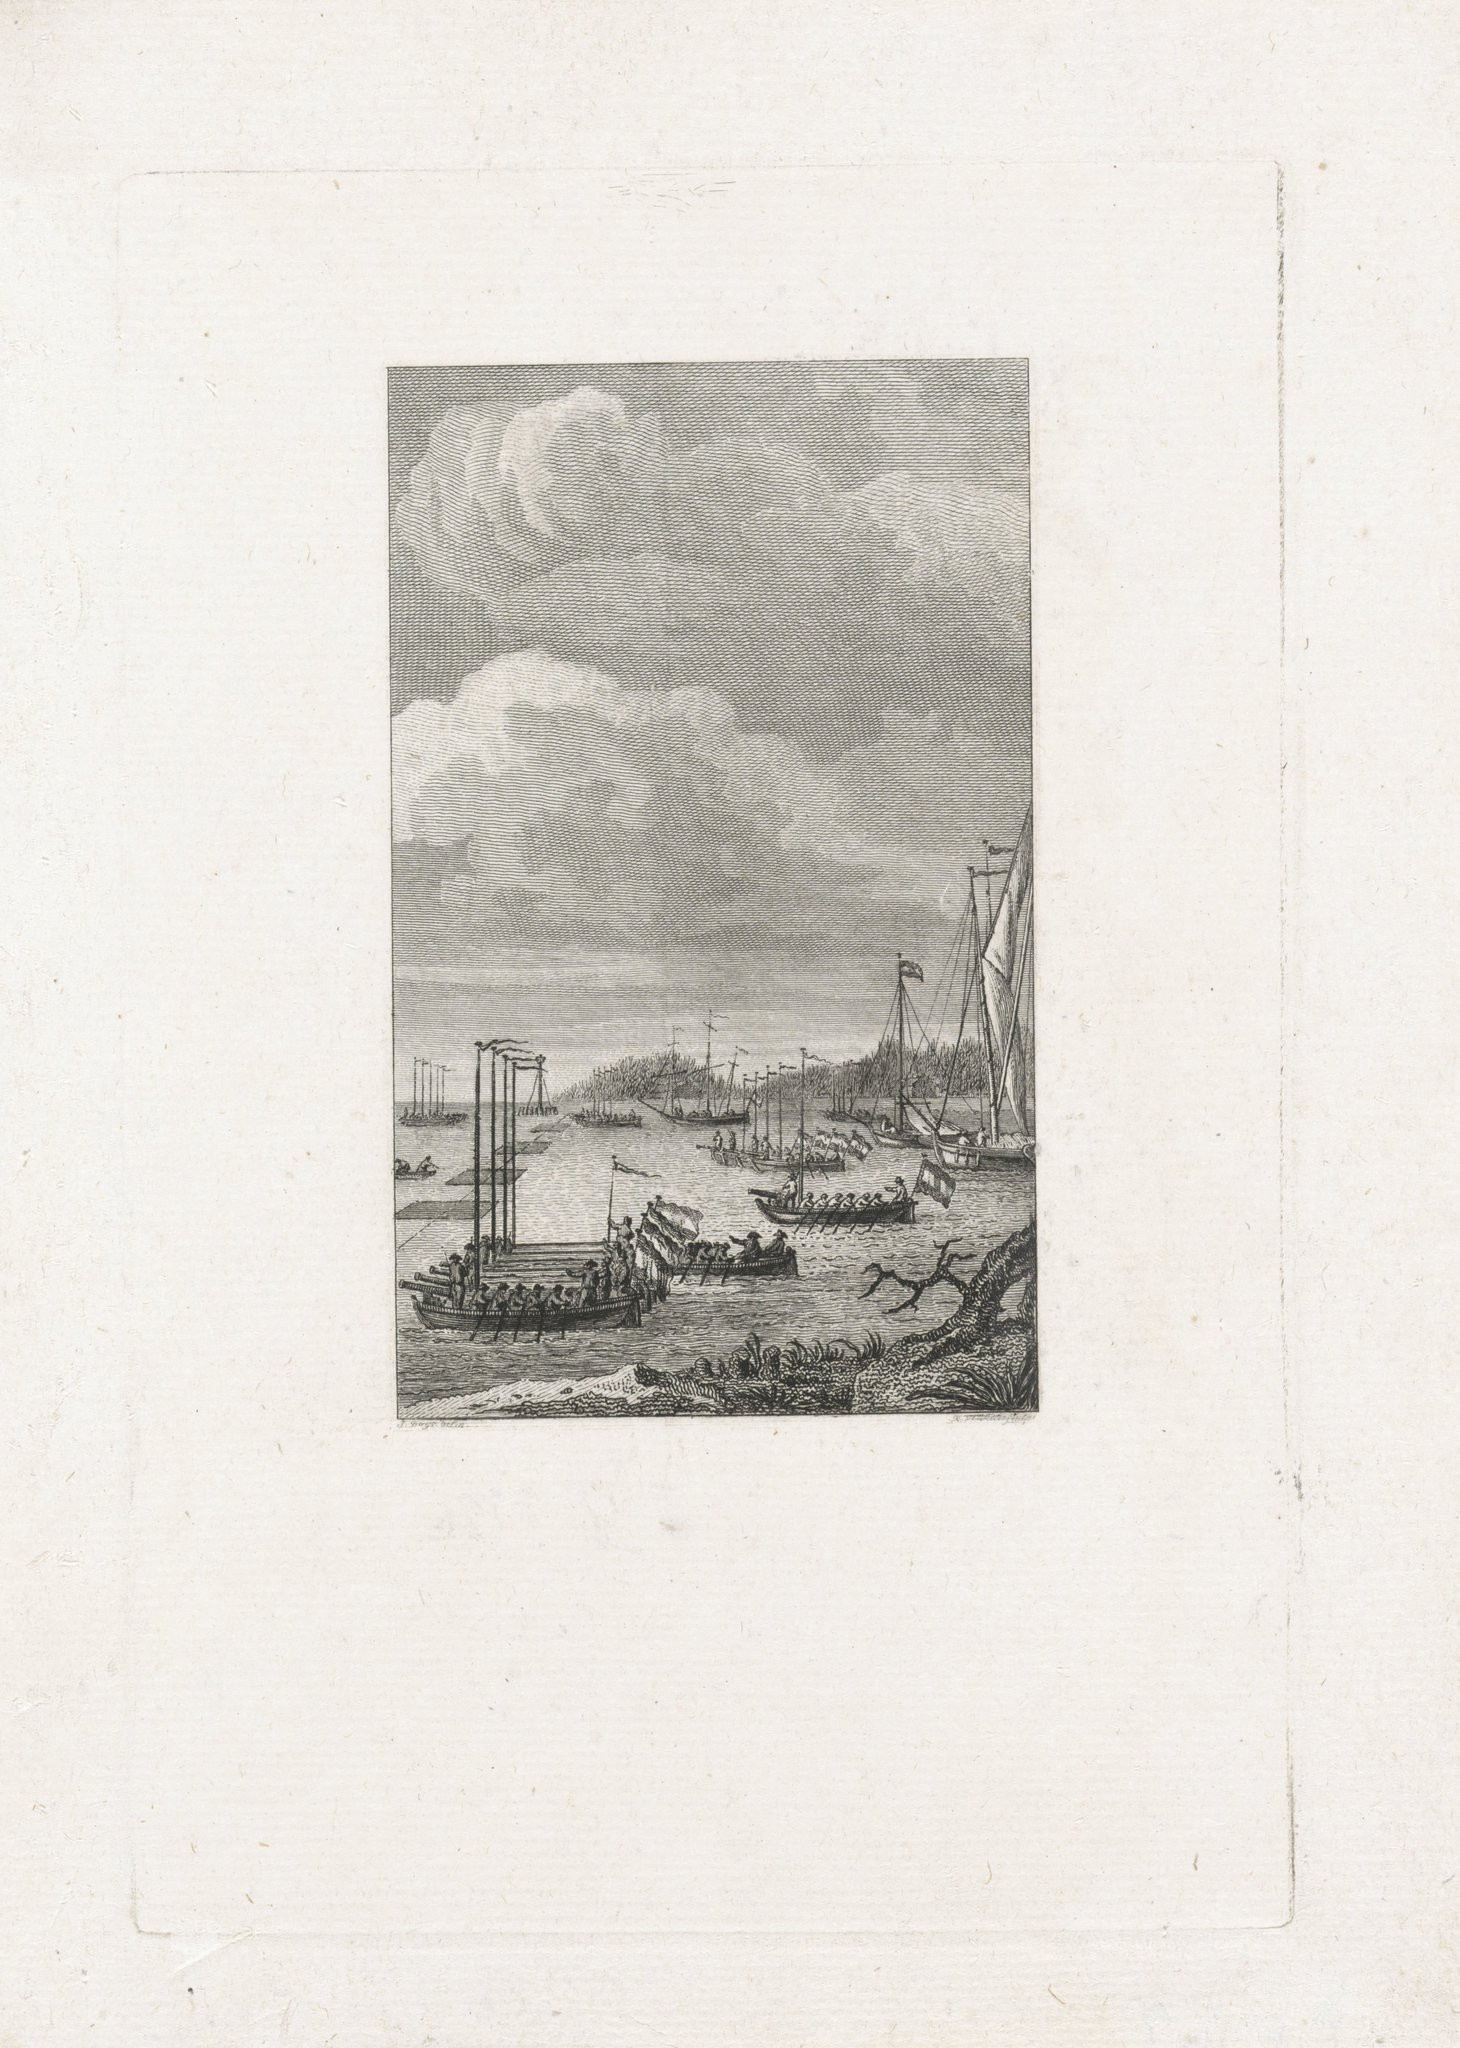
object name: history print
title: Kanonneersloepen in de Dordtsche Kil, 1793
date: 1800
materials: paper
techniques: engraving, etching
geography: northern netherlands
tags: chains across waterway, rowing-boat, canoe, etc.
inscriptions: collector's mark: Lugt 2228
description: Gebruikt als illustratie in: P.A. Loosjes. Vaderlandsche historie, vervattende de geschiedenissen, der Vereenigde Nederlanden (...). Ten onmiddelyken vervolge van Wagenaar's Vaderlandsche historie. Amsterdam: Johannes Allart, dl. 25 (1800), p. 442. Gekopieerd naar de prent van Bendorp naar Schouman, zie FMH 5208.